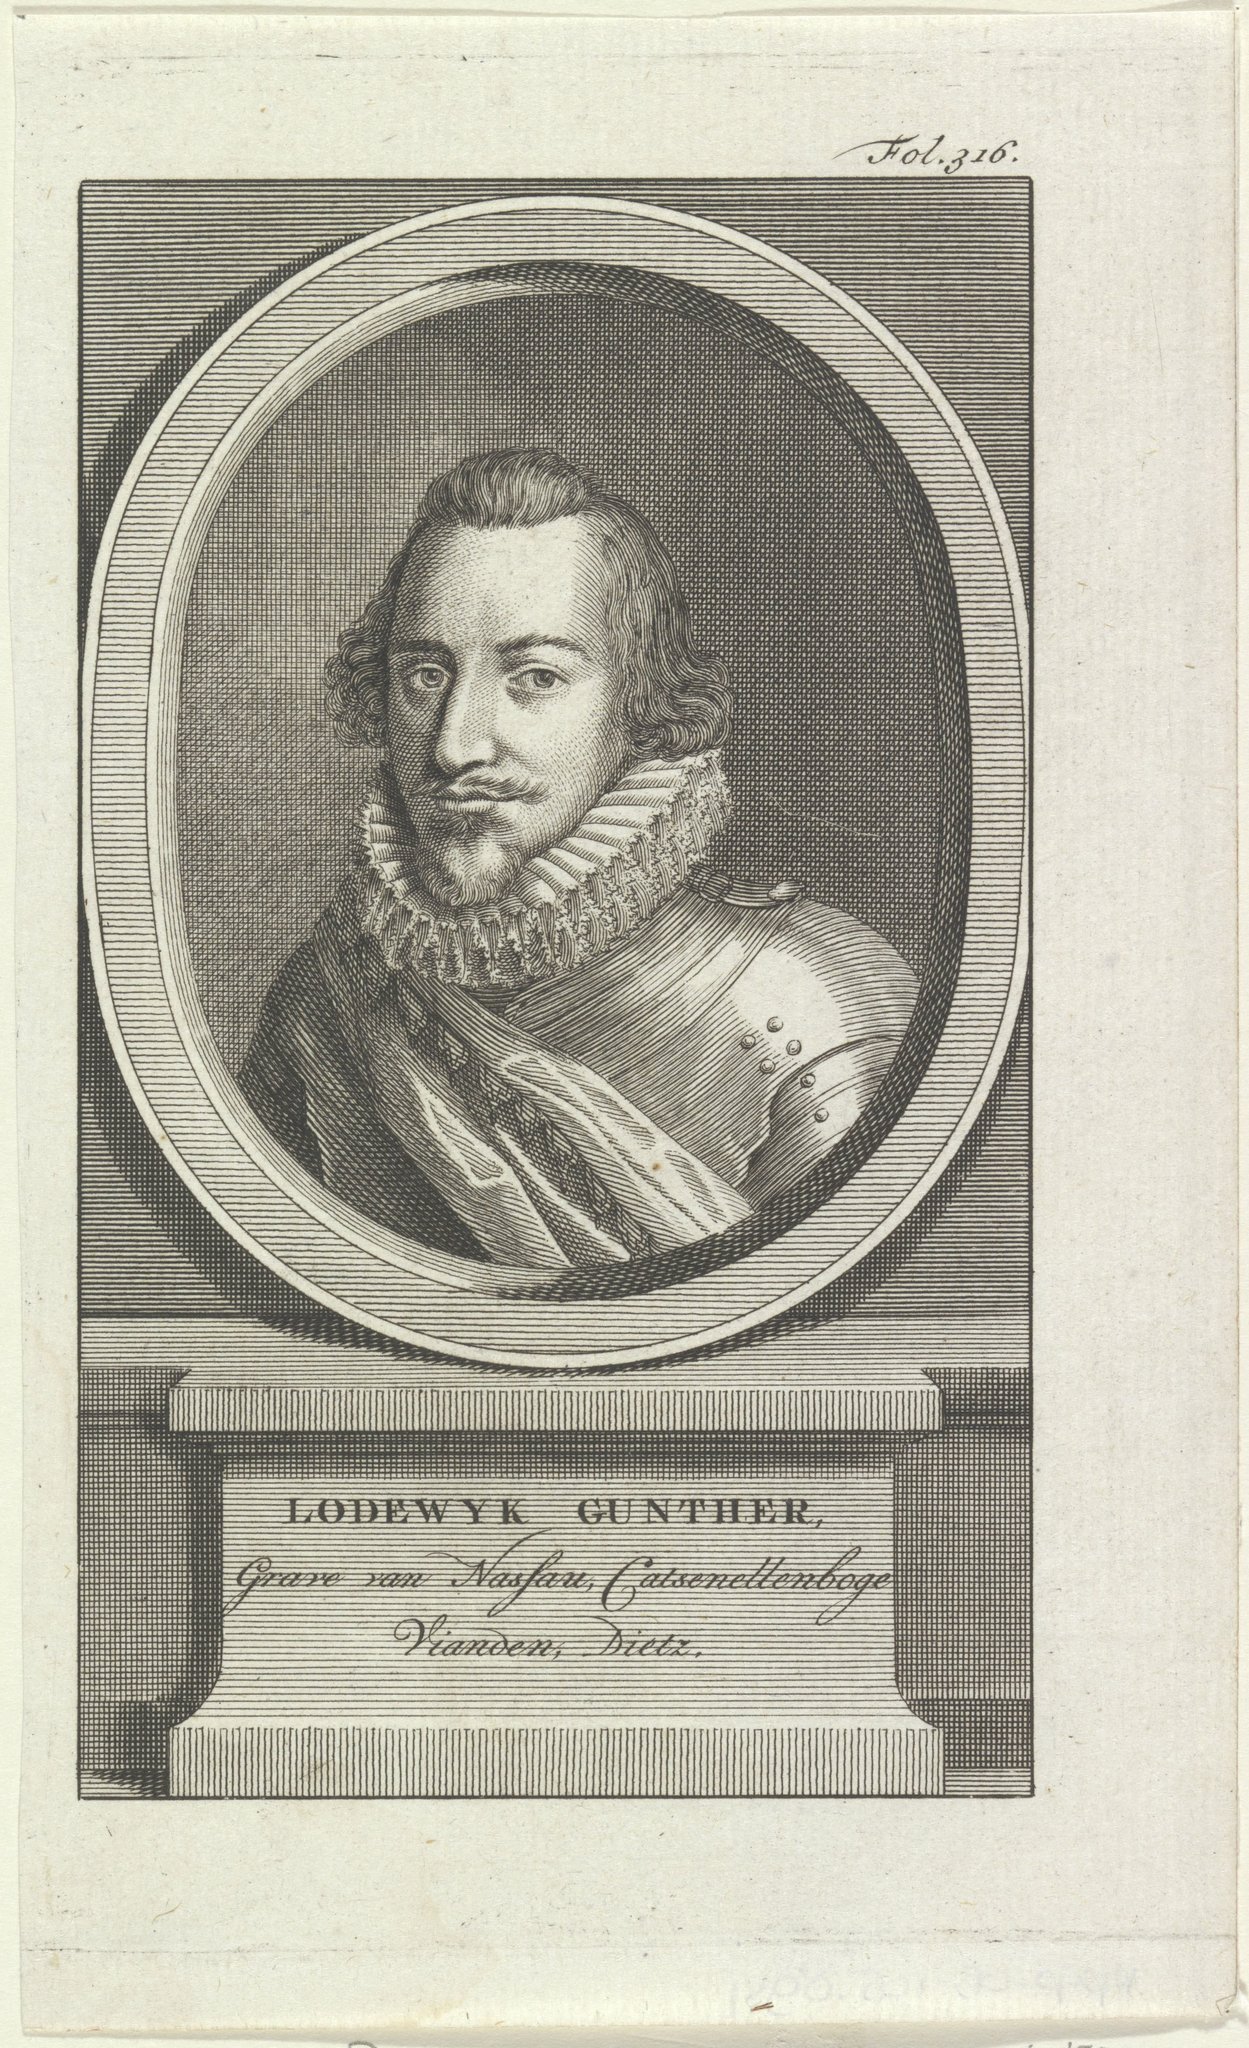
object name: print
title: Portret van Lodewijk Gunther, graaf van Nassau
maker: jan punt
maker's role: draughtsman, print maker, publisher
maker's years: 1711-1779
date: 1731-1779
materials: paper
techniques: engraving, etching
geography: northern netherlands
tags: dillenburg, sluis, lodewijk gunther graaf van nassau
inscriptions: collector's mark: Lugt 2228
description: De hier vermelde titel verwijst naar de hoogst verkregen titel van de geportretteerde, niet per se naar de titel die de geportretteerde op deze voorstelling draagt.